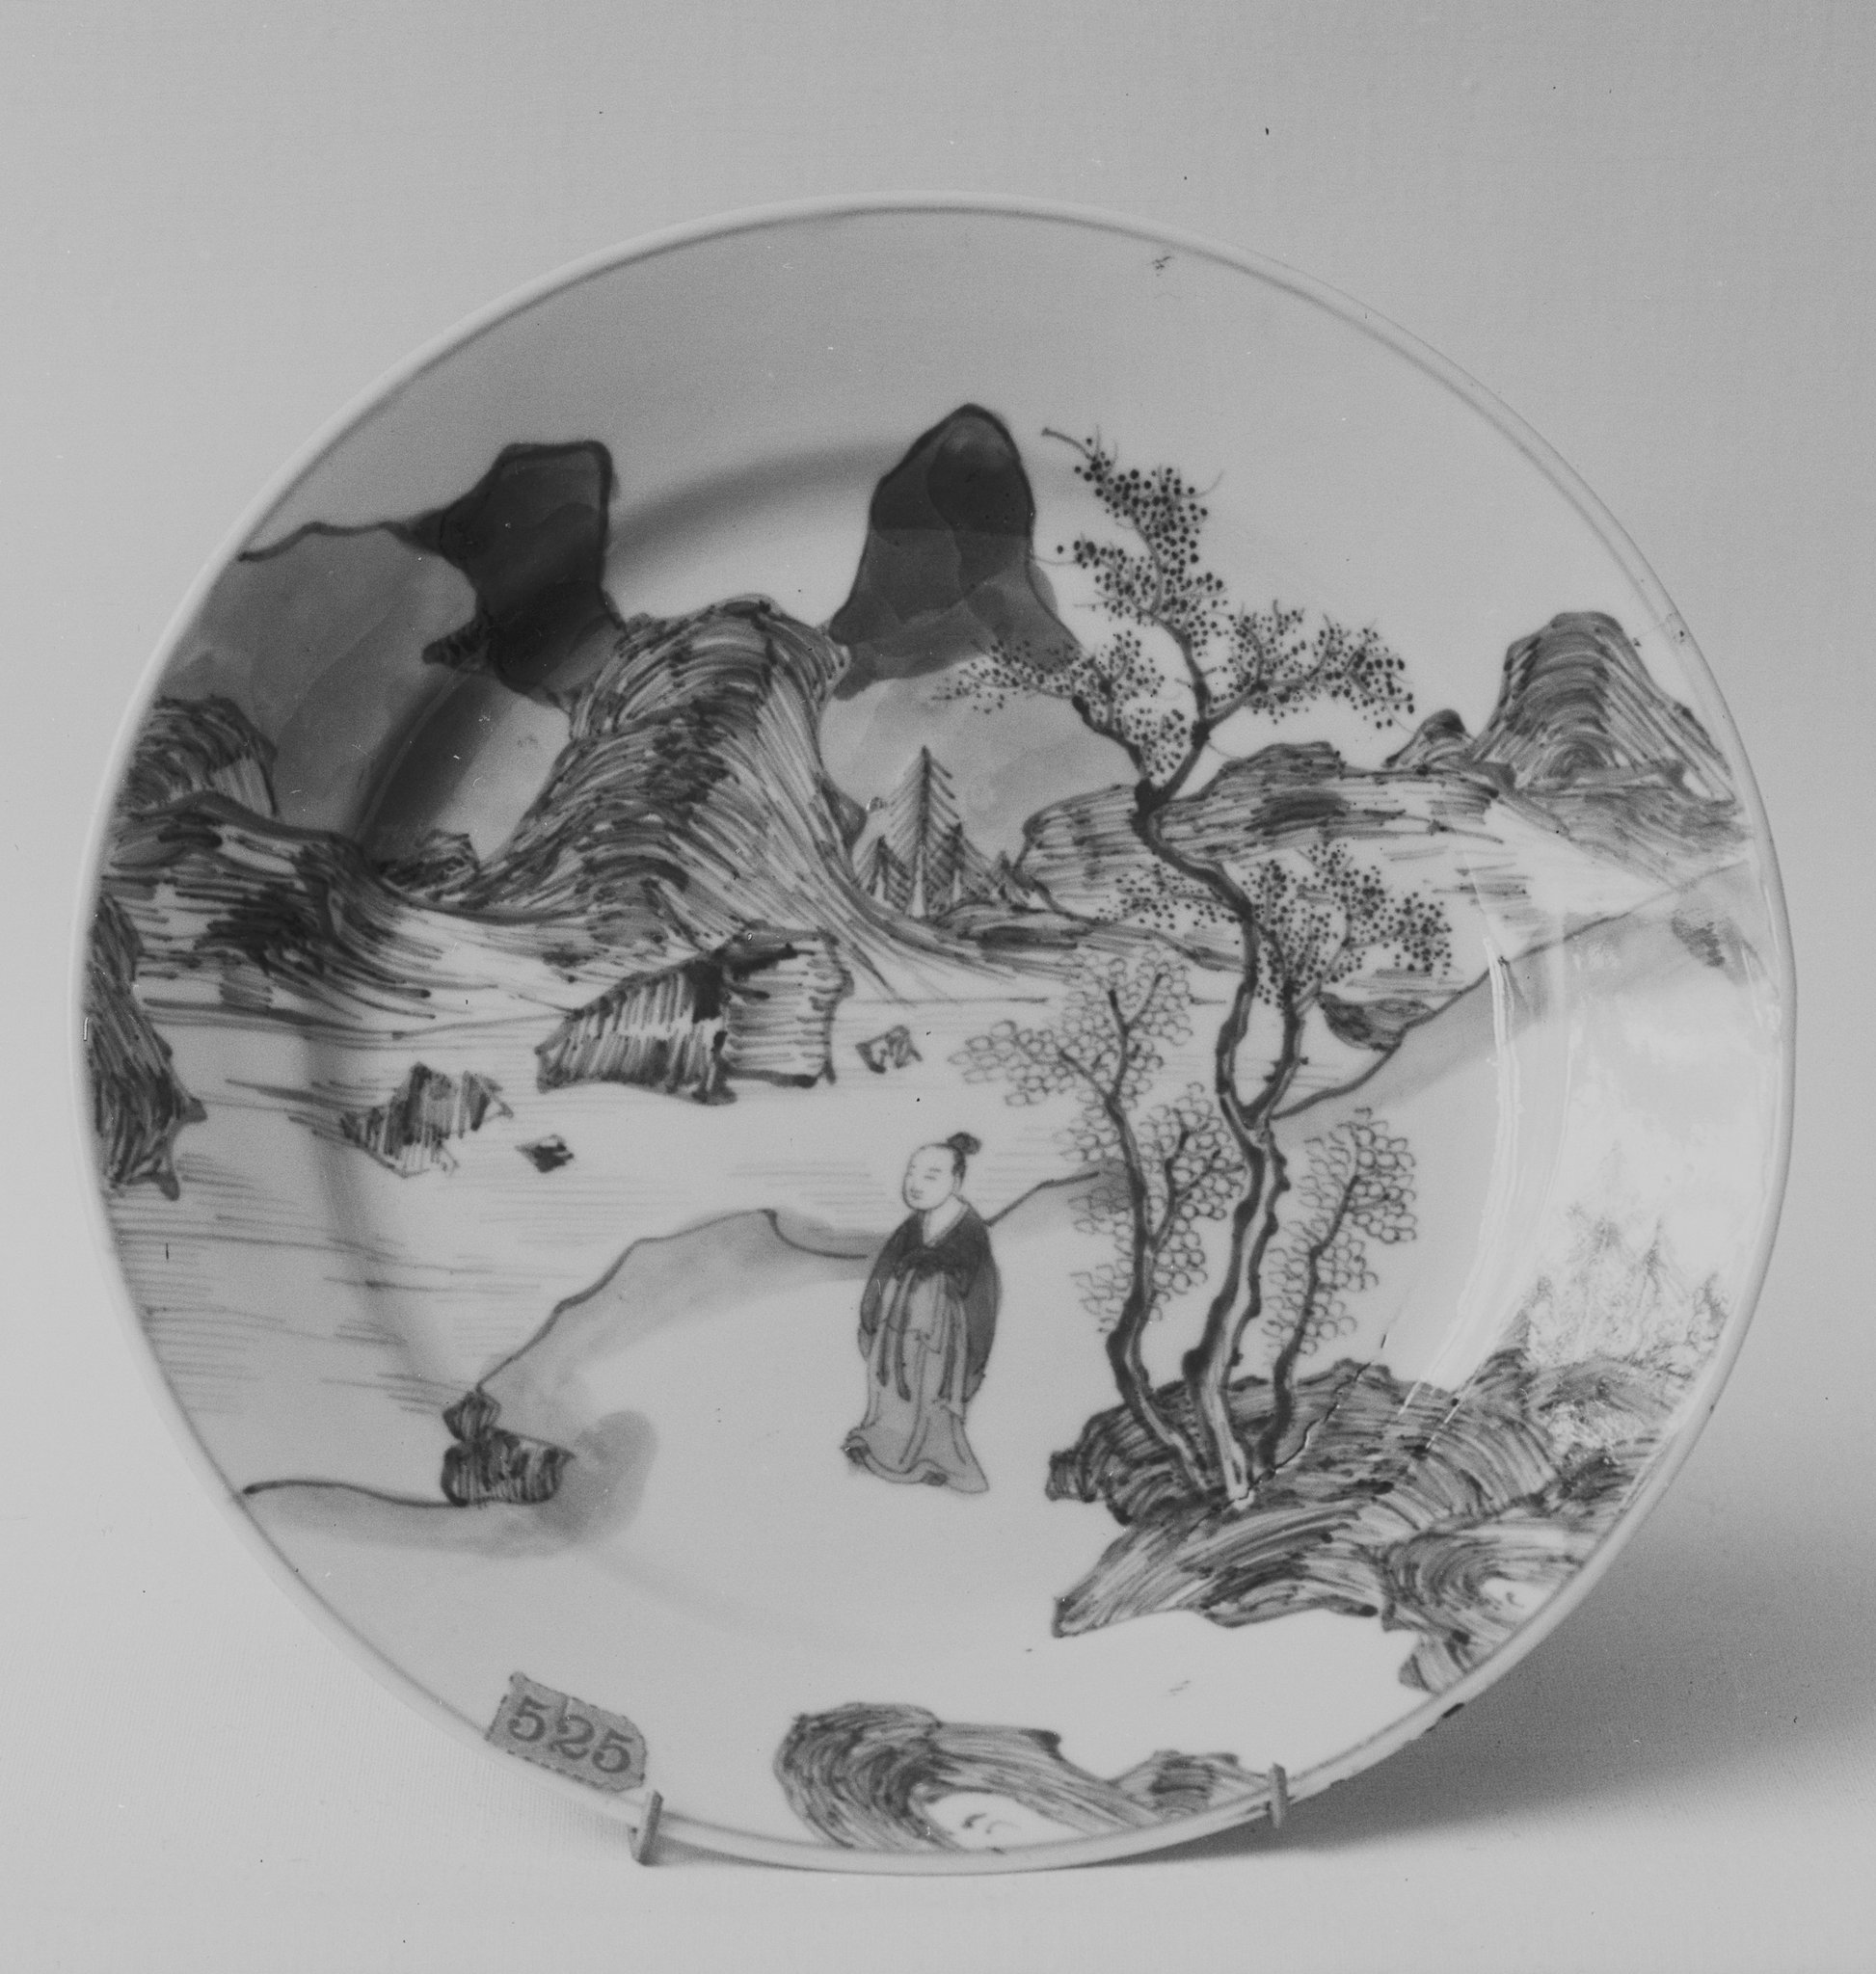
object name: dish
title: Dish with Scholar in a Landscape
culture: chinese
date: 1655-1670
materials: cobalt, glaze, porcelain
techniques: painting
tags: men,mountains,landscapes